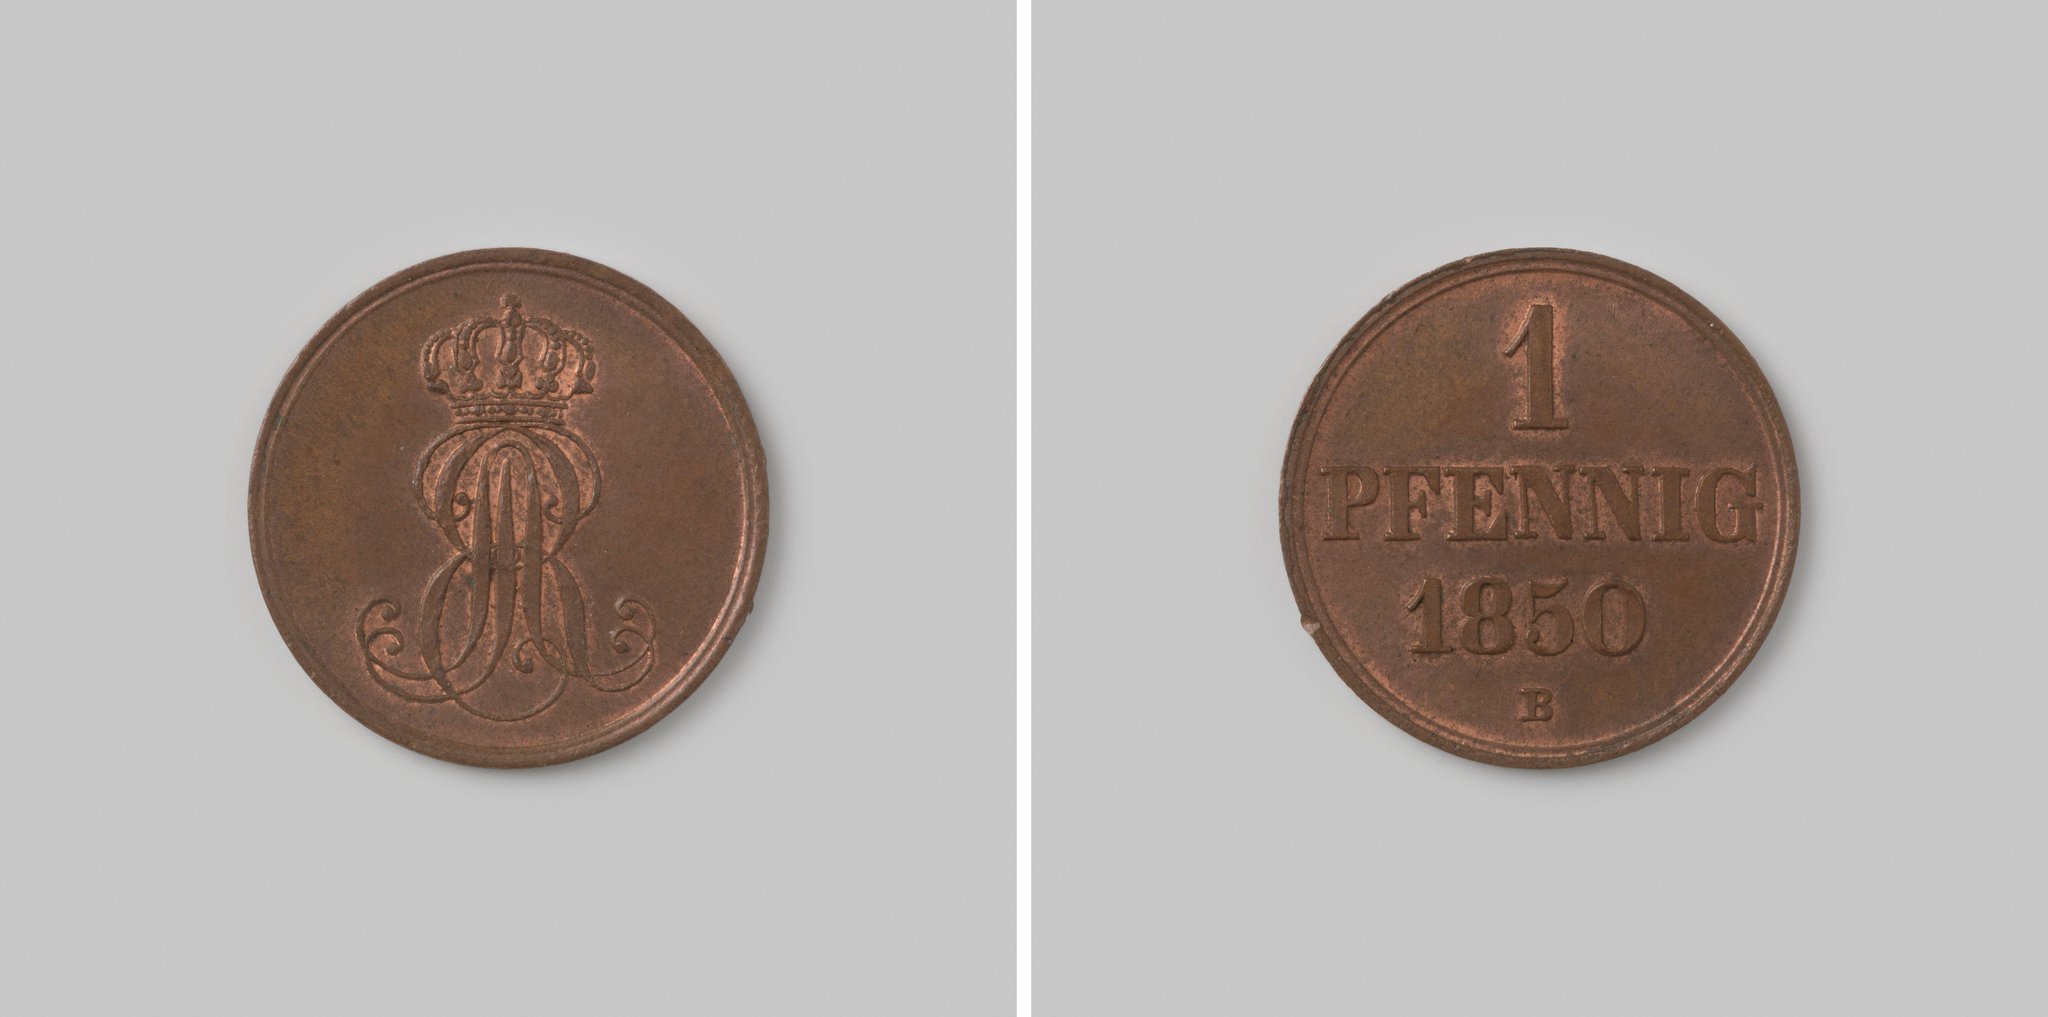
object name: coin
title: Pfennig uit het koninkrijk Hannover van Ernst August, 1850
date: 1850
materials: copper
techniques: striking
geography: hannover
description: Koperen munt. Voorzijde: gekroond monogram. Keerzijde: waarde-aanduiding in twee regels, waaronder jaartal. Daaronder letter B. Gladde rand.